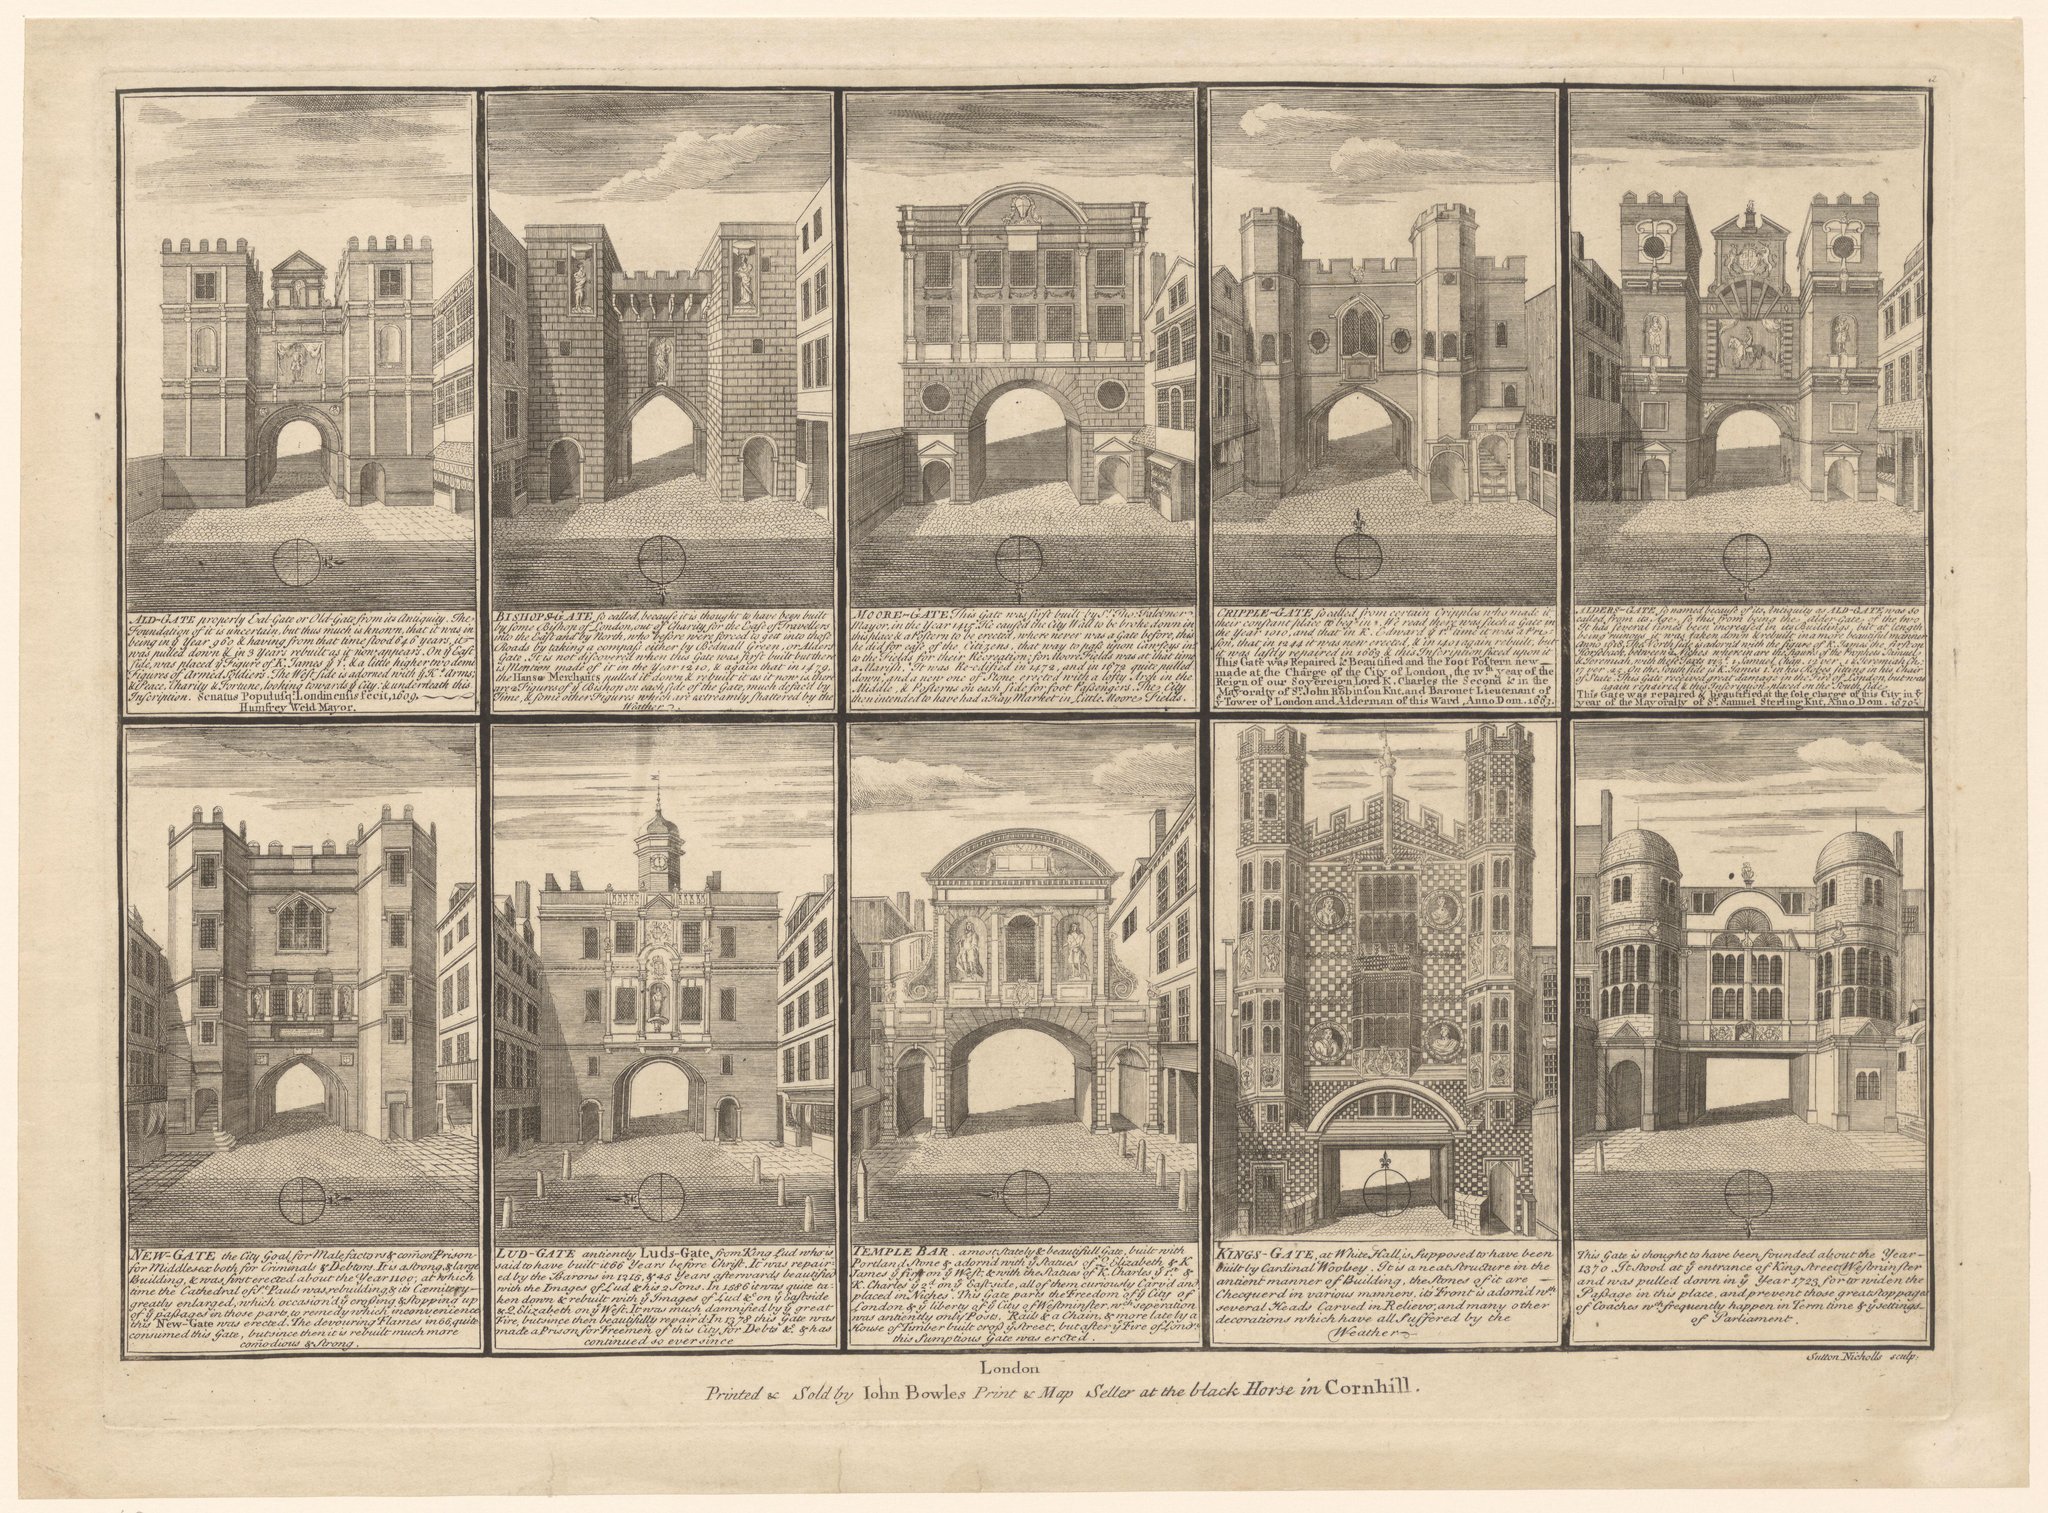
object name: print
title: London Described; or Perspective Views and Elevations of Noted Buildings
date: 1731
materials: paper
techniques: etching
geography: london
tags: city-gate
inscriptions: collector's mark: Lugt 2228